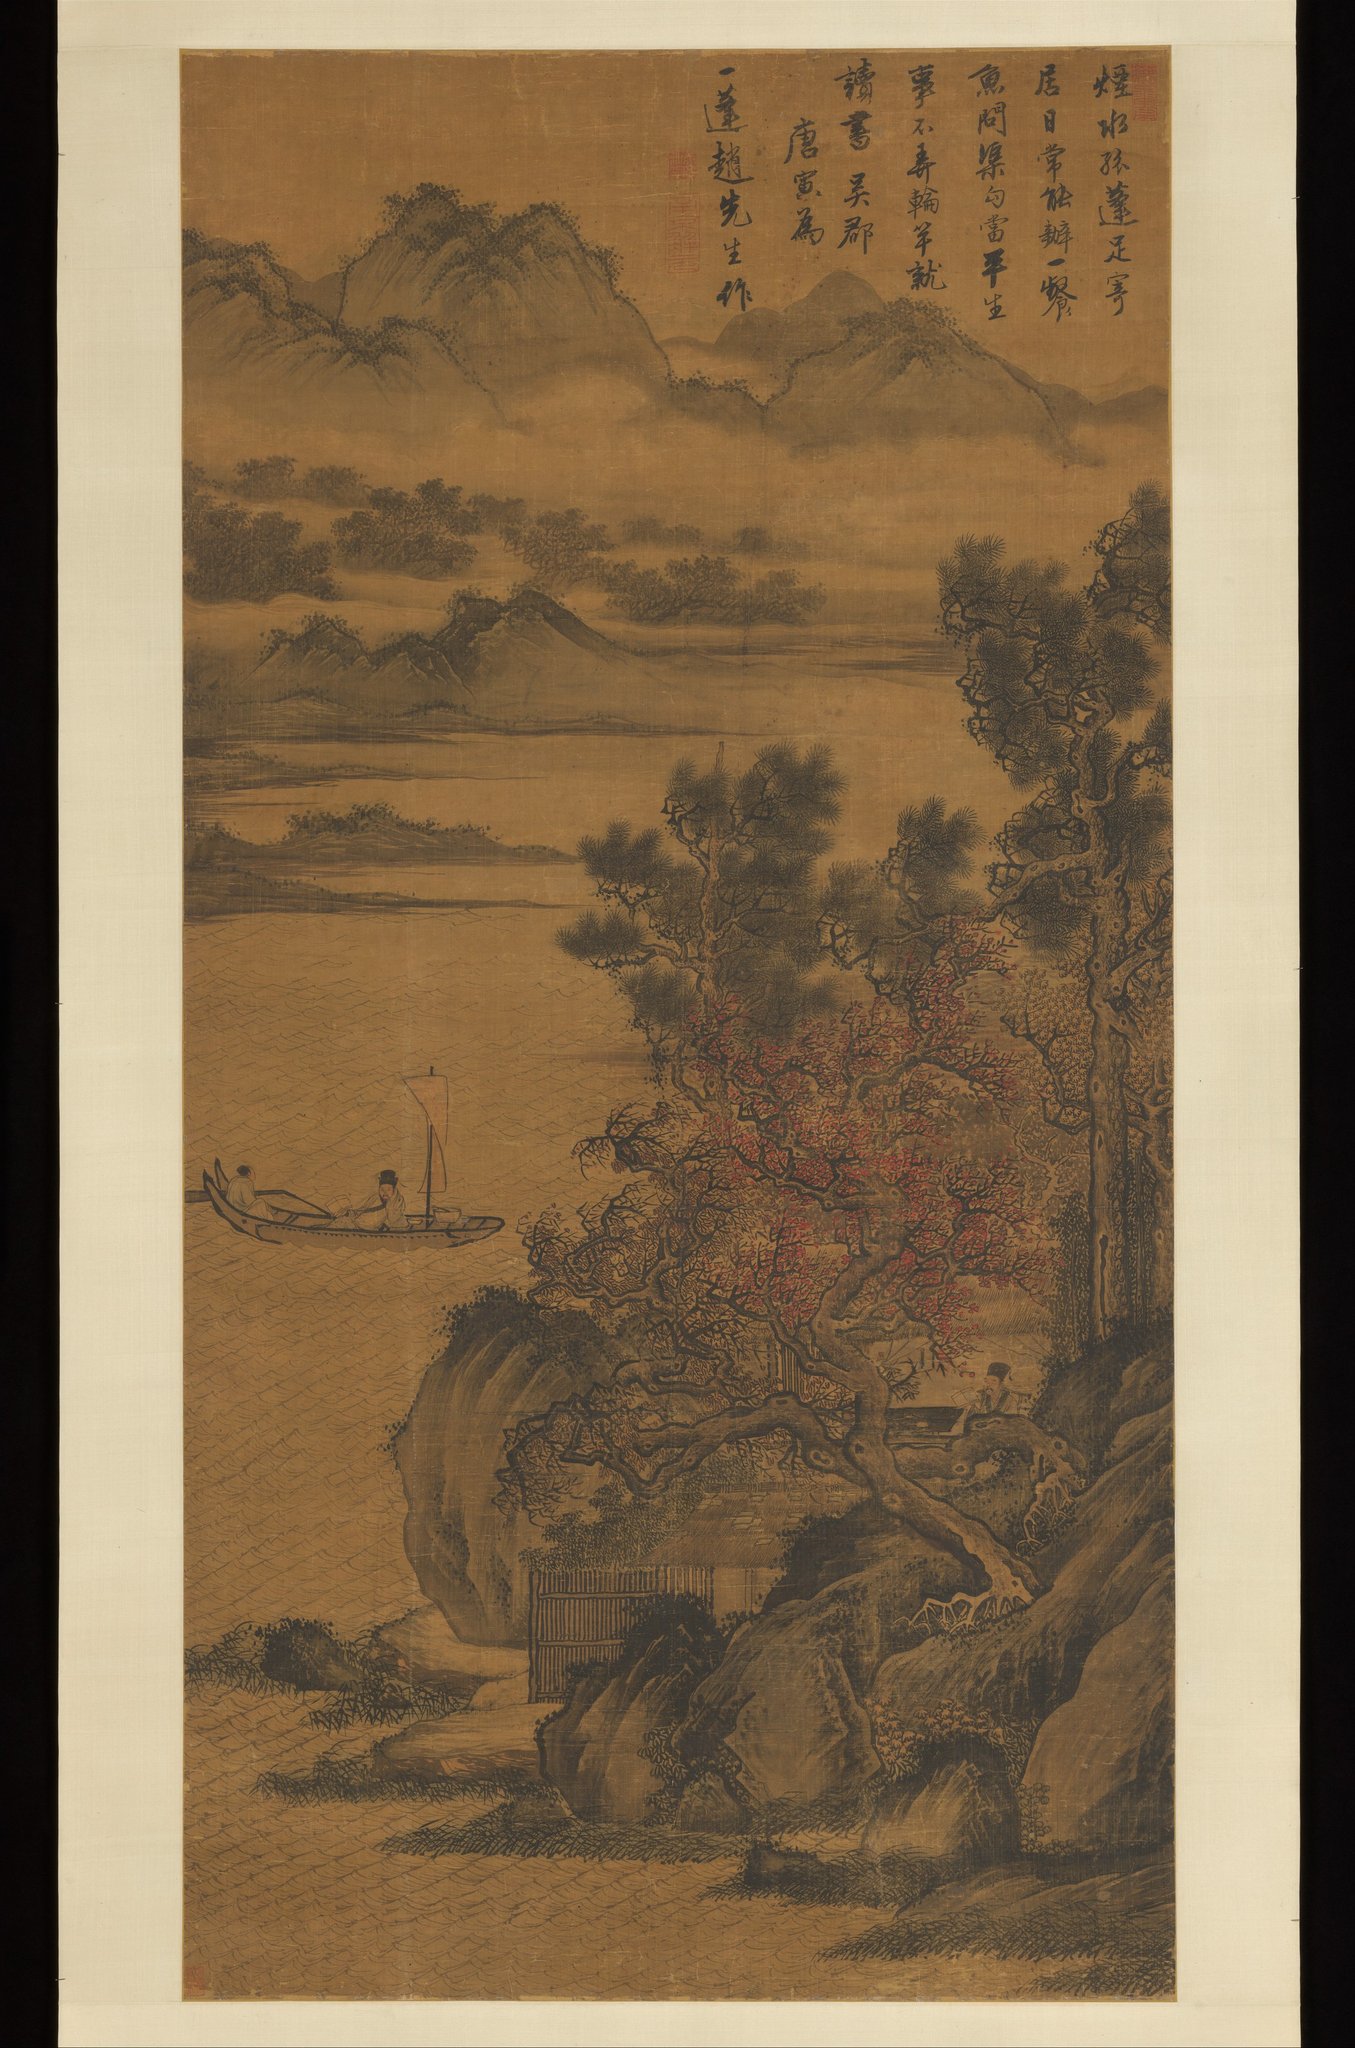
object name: hanging scroll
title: Landscape for Zhao Yipeng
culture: chinese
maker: tang yin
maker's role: artist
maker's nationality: chinese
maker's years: 1470-1524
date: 1467-1533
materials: ink, silk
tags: landscapes,trees,boats